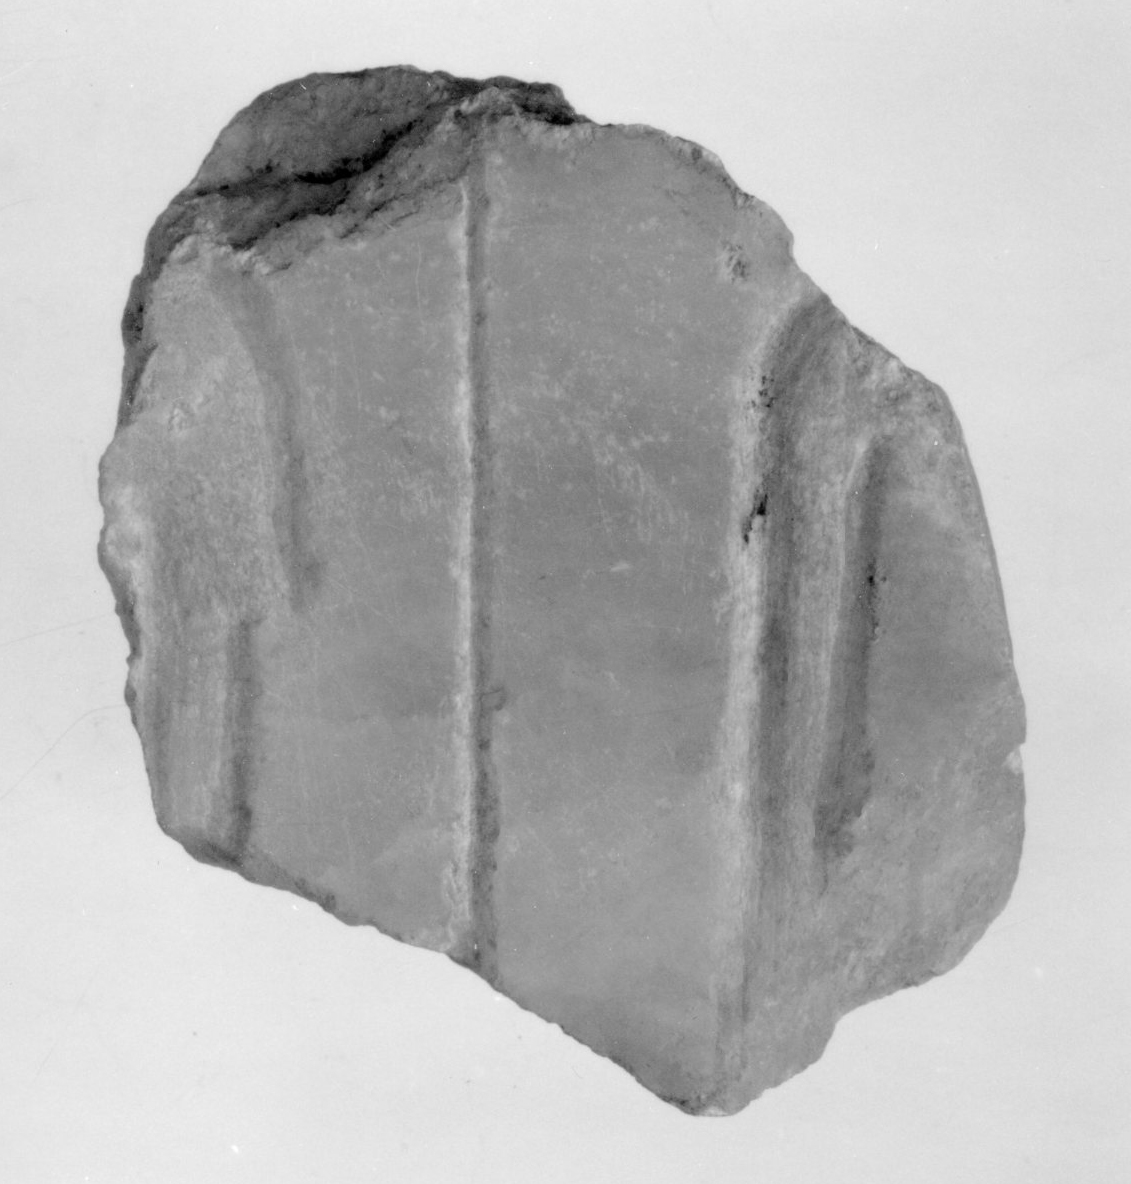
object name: canopic box, siptah, center side, drawing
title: Decorated fragment from the side of a canopic chest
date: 1194-1188 BCE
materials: stone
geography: egypt